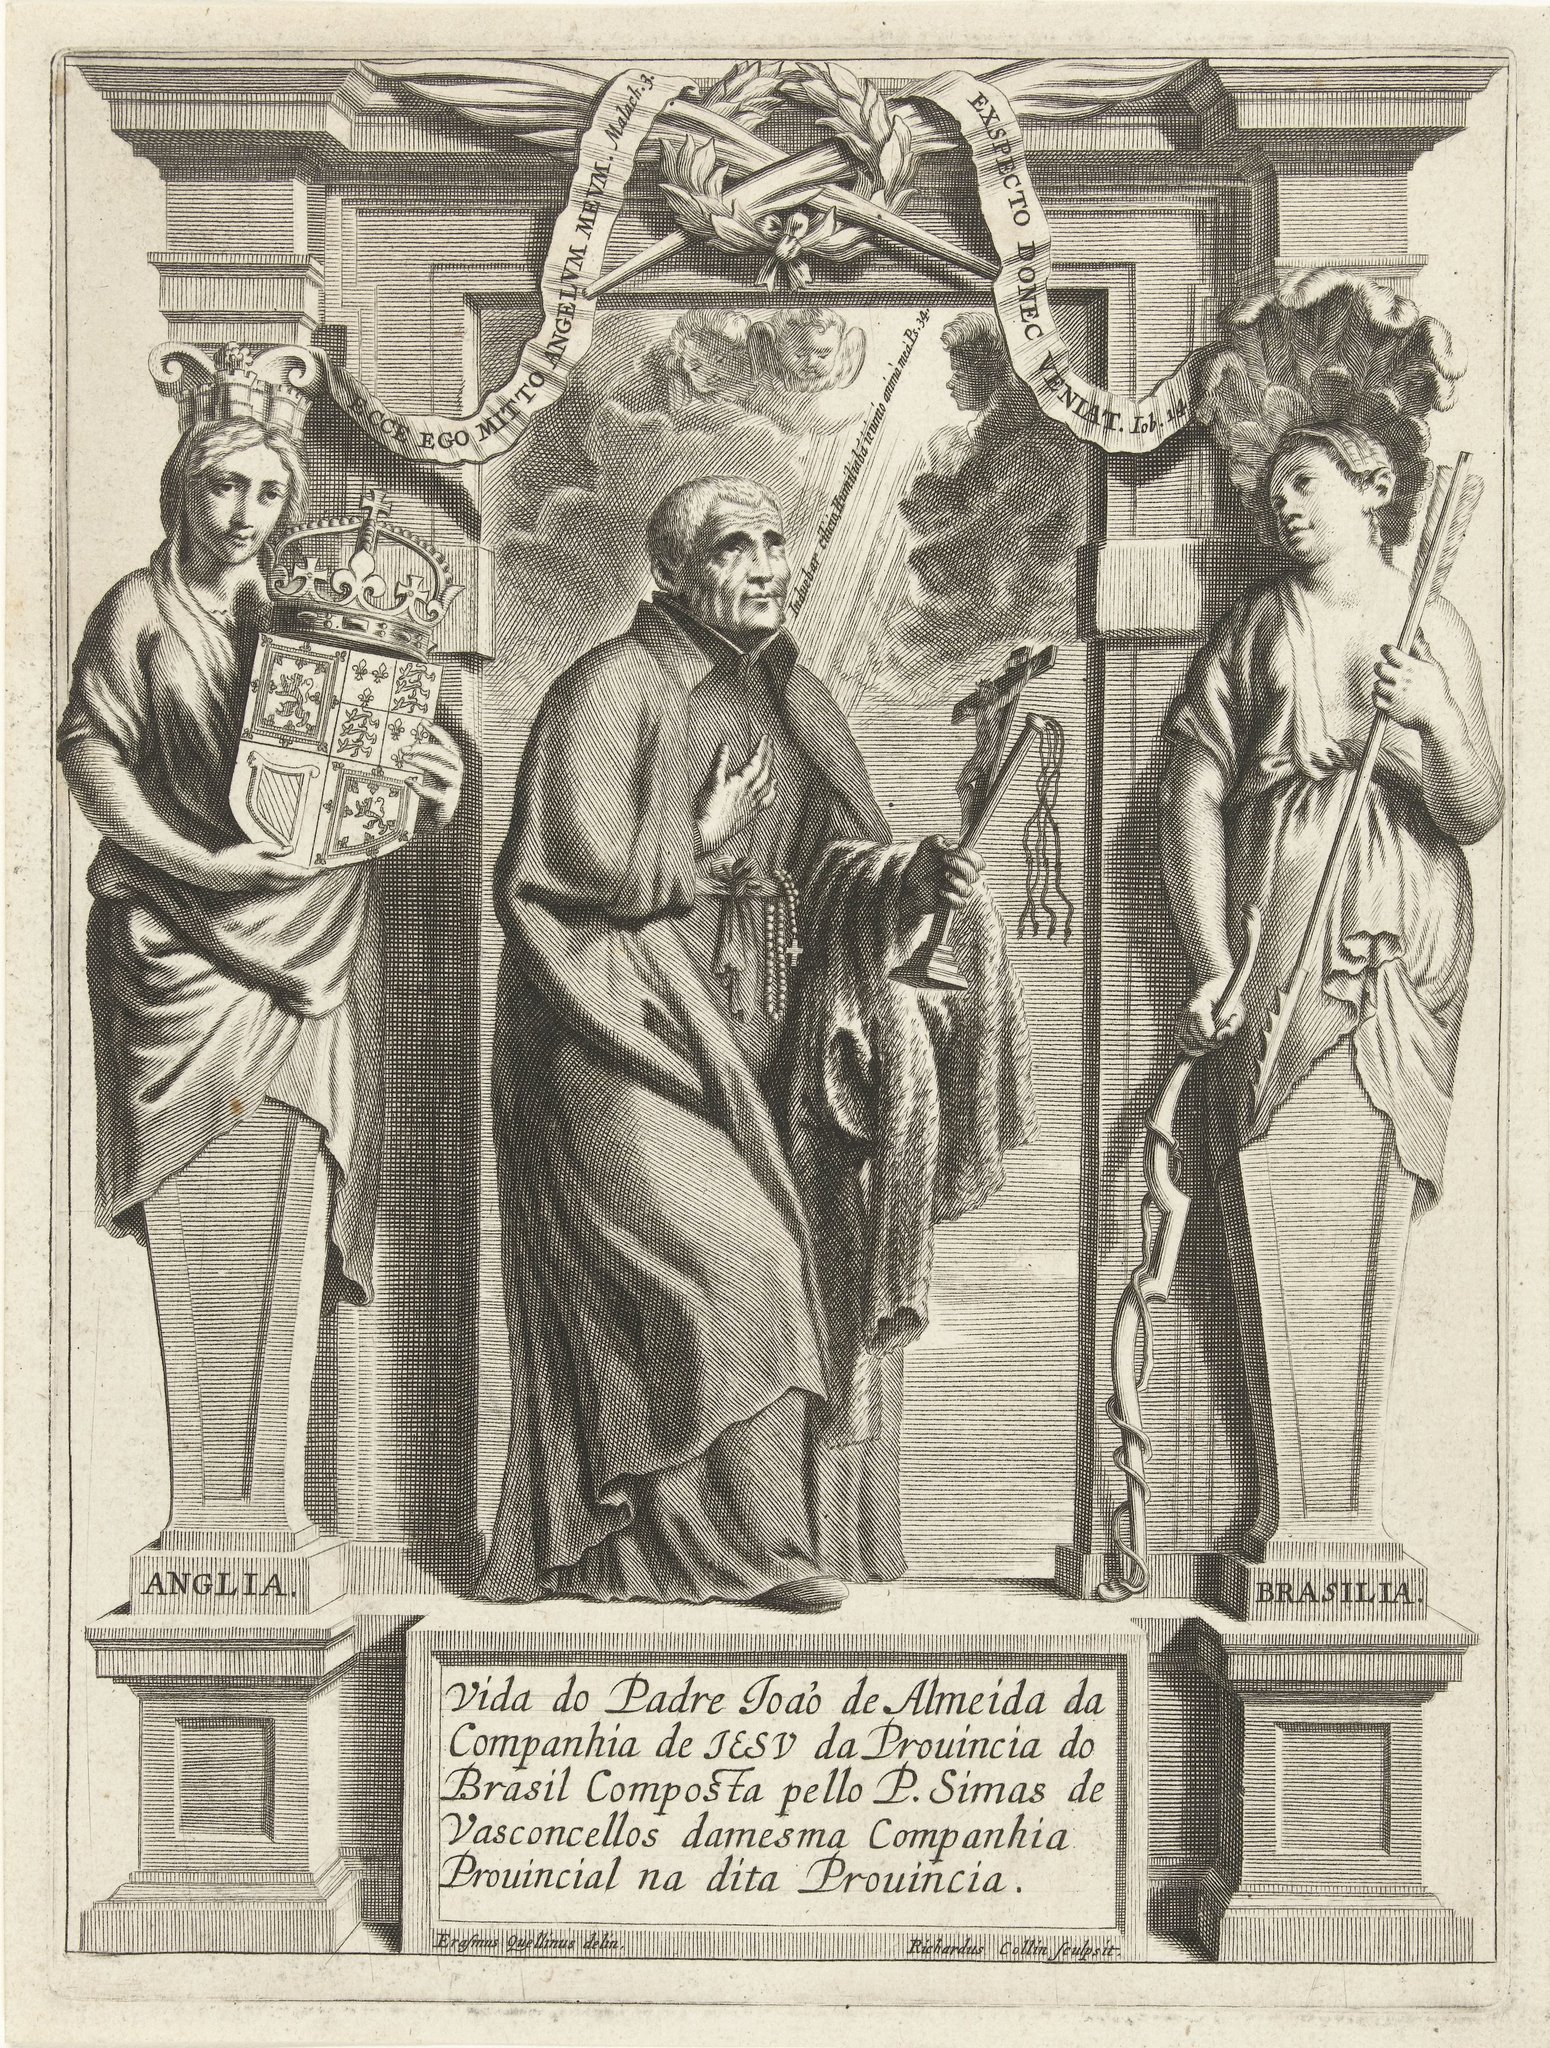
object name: print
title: Portret van de jezuïet João de Almeida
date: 1660-1680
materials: paper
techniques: engraving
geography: antwerp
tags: batavia, missionary, regular clerics, e.g. jesuits, redemptorists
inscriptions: collector's mark: Lugt 2228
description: João de Almeida, staande, de rechterhand op zijn borst en in de andere hand een gesel en een crucifix. Aan weerszijden twee kariatiden: links Anglica, zijn geboorteland, rechts Brasilia het land waar hij in de missie werkte.